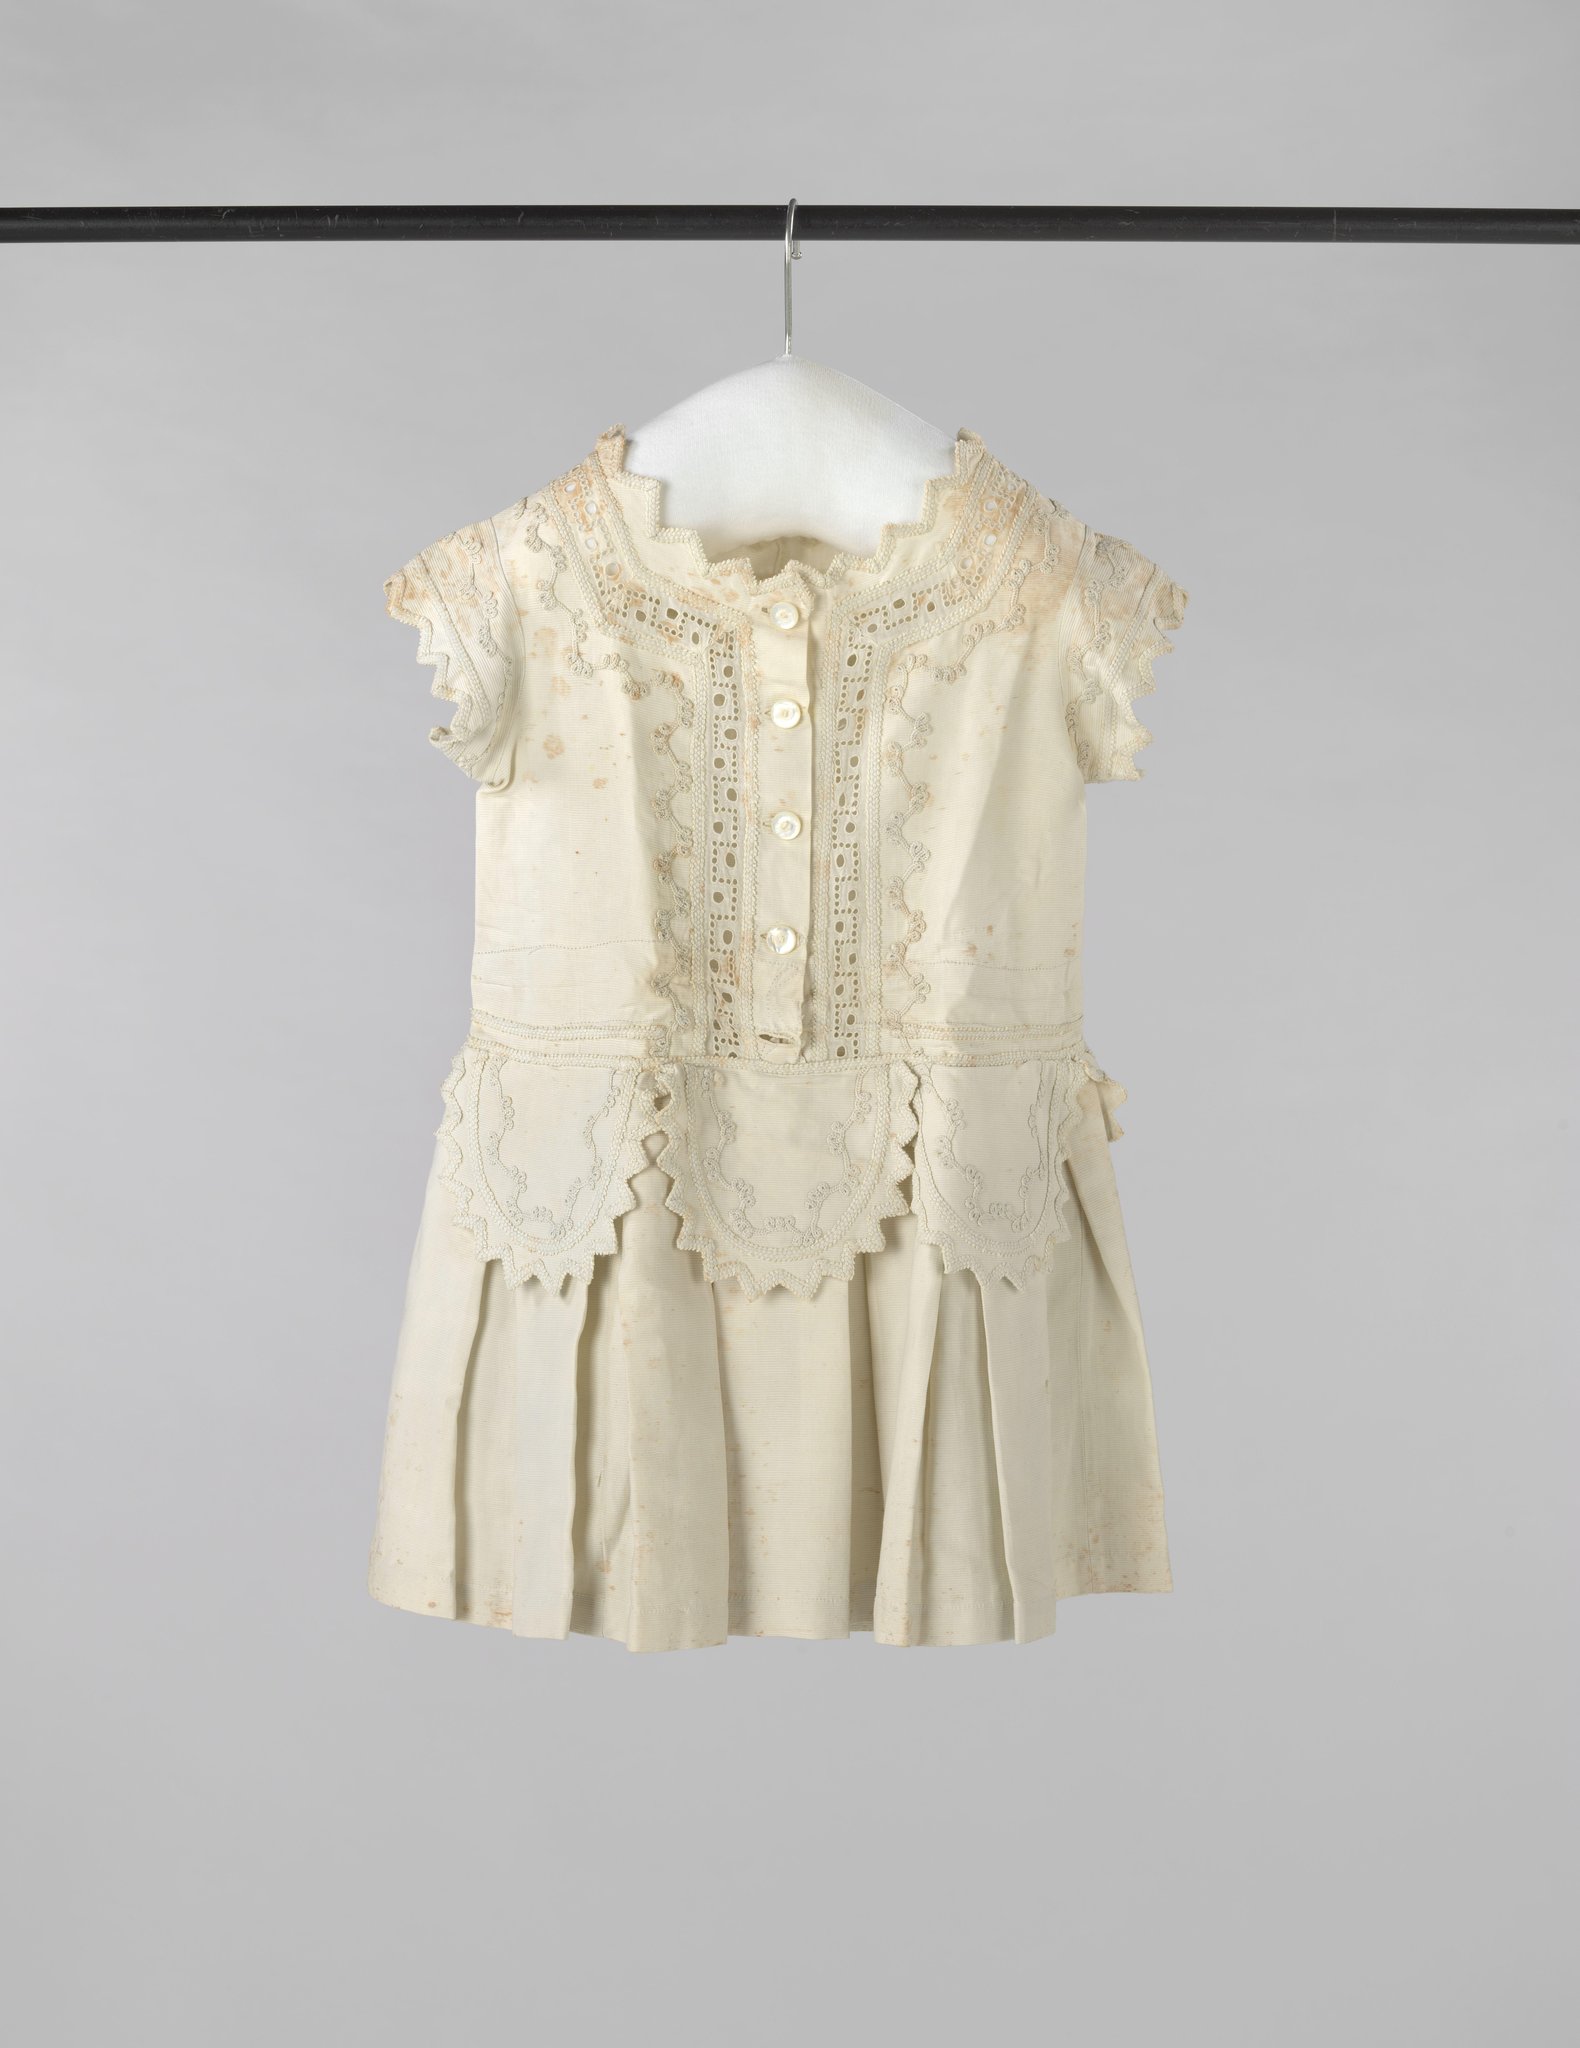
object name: clothing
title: Kinderjurk van witte katoenen piqué, met passement, soutache en zigzagranden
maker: Anonymous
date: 1890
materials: cotton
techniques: weave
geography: netherlands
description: Kinderjurk van witte katoenen piqué. Glad lijfje. Knoopsluiting van achteren. Schuitvormige hals. Wijde armsgaten en zeer korte gladde mouwtjes. Het rokje is romdom in stolpplooien gelegd, terwijl in de taille zes ronde aansluitende slippen opgenaaid zijn. De hals, de mouwtjes en de slippen zijn zigzagvormig uitgetand en met passement en krullend soutache belegd, terwijl langs de sluiting en de hals een open handgeborduurd entre-duex is tussengezet.